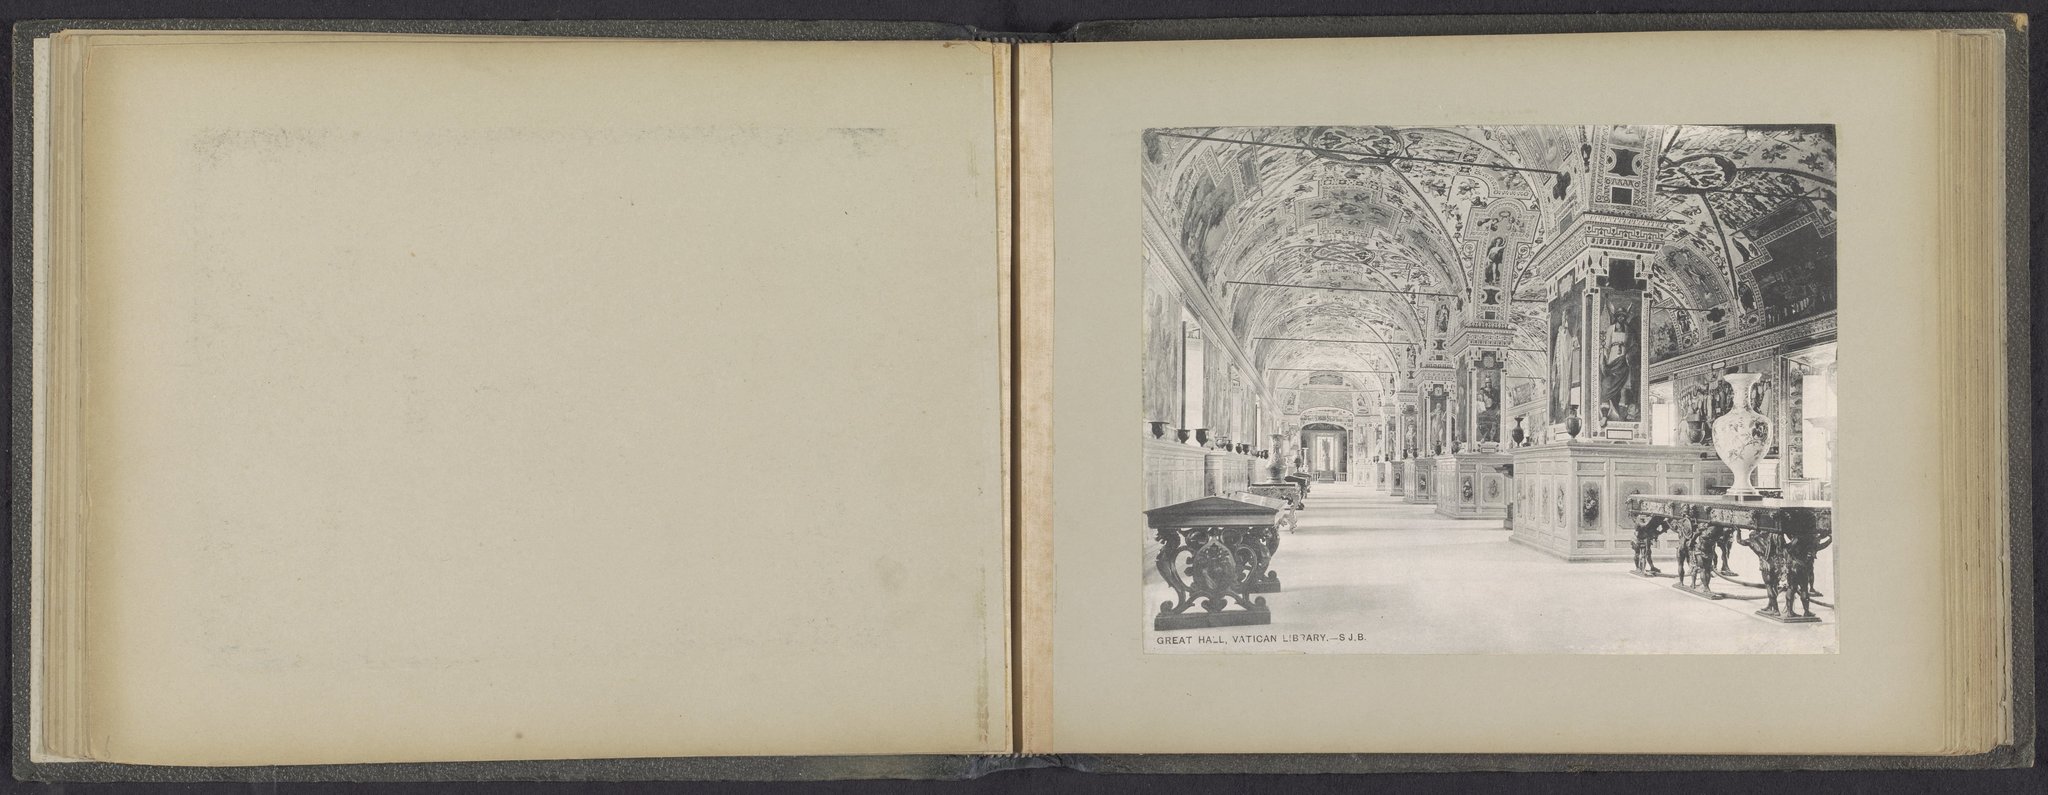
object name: photomechanical print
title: Great hall, Vatican library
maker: samuel j. beckett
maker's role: fotograaf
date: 1890-1900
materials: paper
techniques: photograph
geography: vatican apostolic library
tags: interior ~ representation of a building, public library